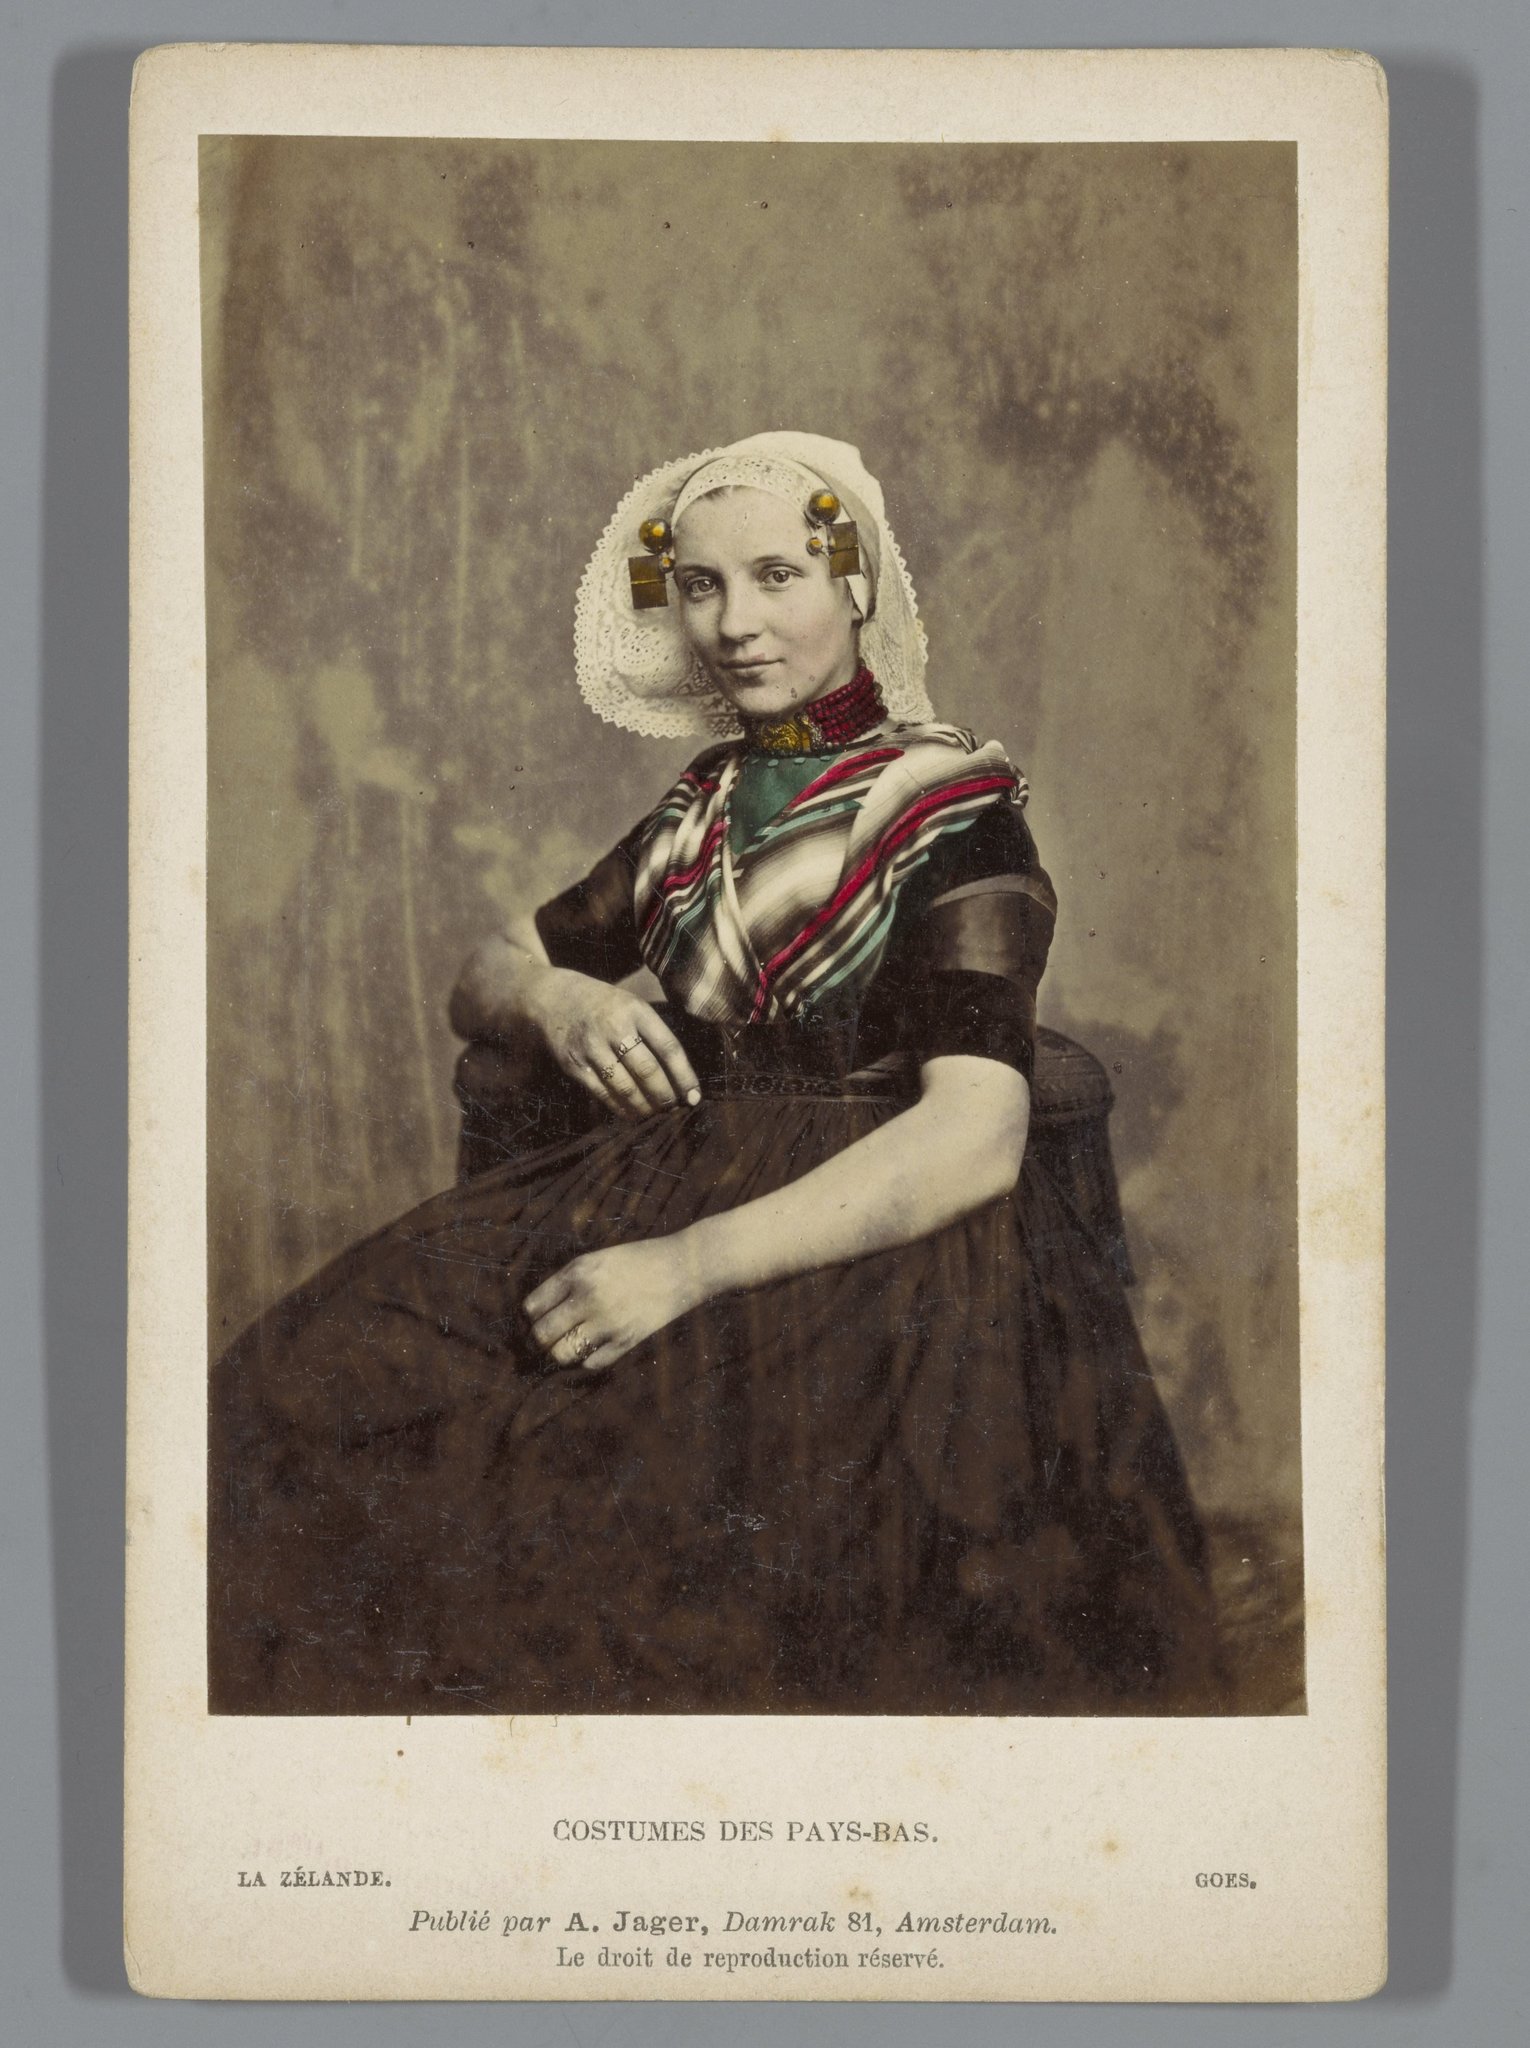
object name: cabinet photograph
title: Costumes des Pays-Bas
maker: andries jager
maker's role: publisher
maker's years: 1825-1905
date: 1860-1890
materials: cardboard, photographic support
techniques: albumen print, hand coloring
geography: amsterdam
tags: historical persons not known by name - bb - woman, folk costume, regional costume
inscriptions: inscription: ‘Publié par A. Jager, Damrak 81, Amsterdam./ Le droit de reproduction réservé.’